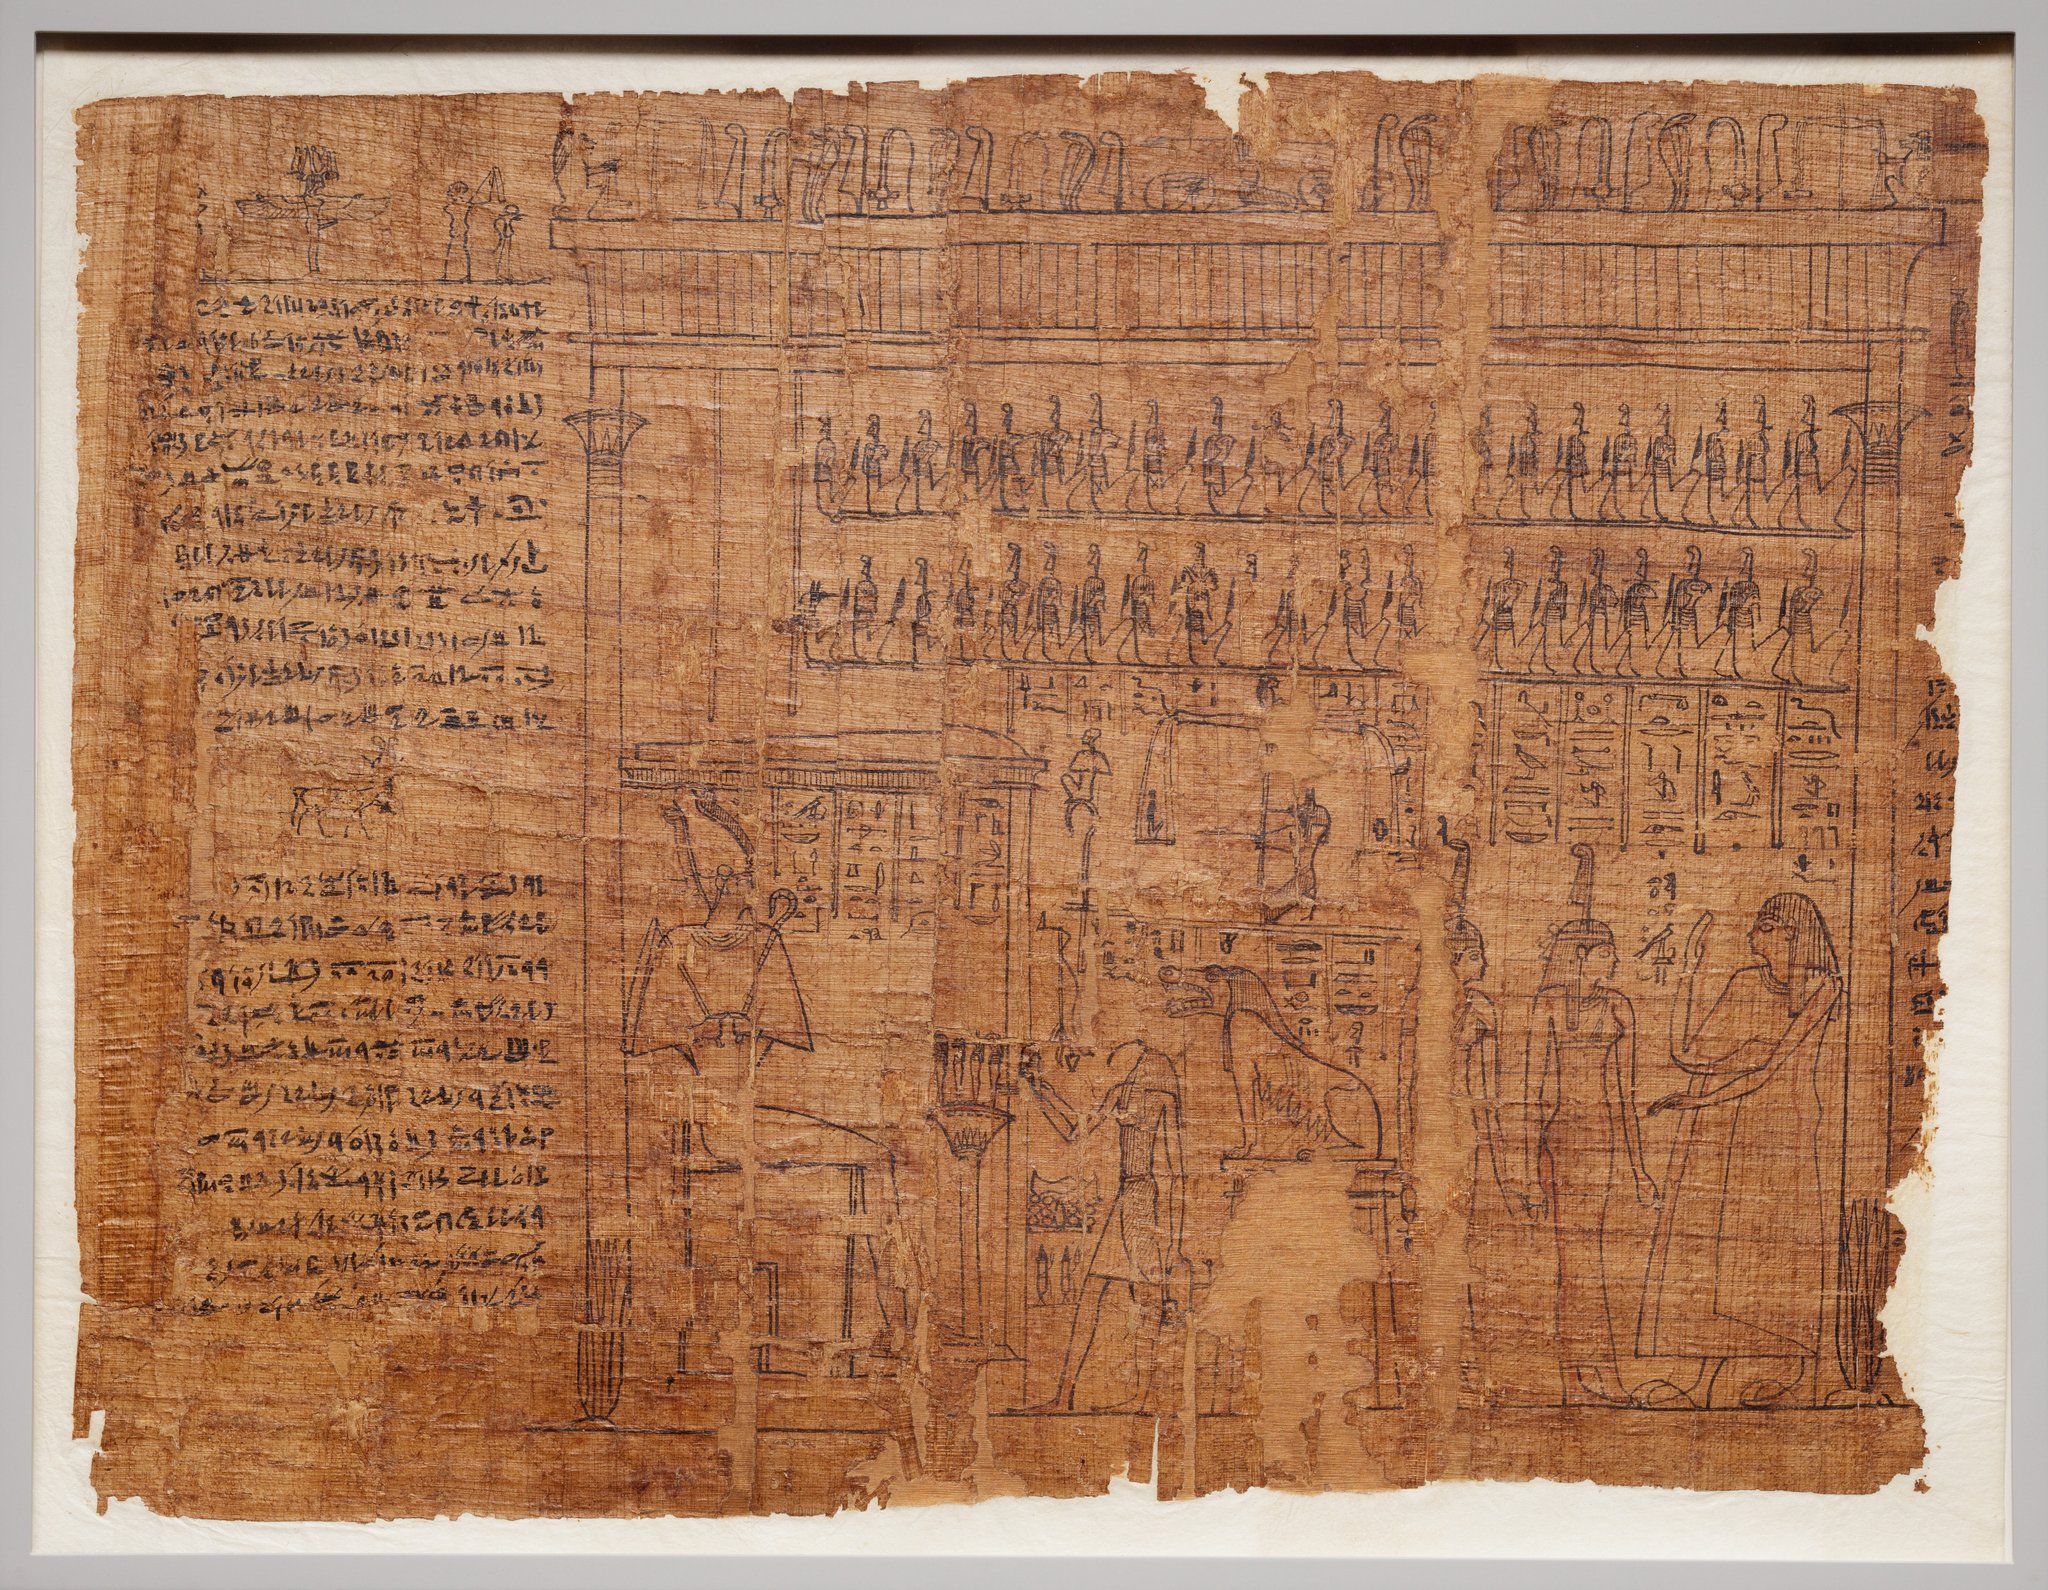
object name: papyrus, funerary, book of the dead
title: Part of a funerary papyrus showing the judgment before Osiris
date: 230-150 BCE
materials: ink, papyrus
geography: egypt